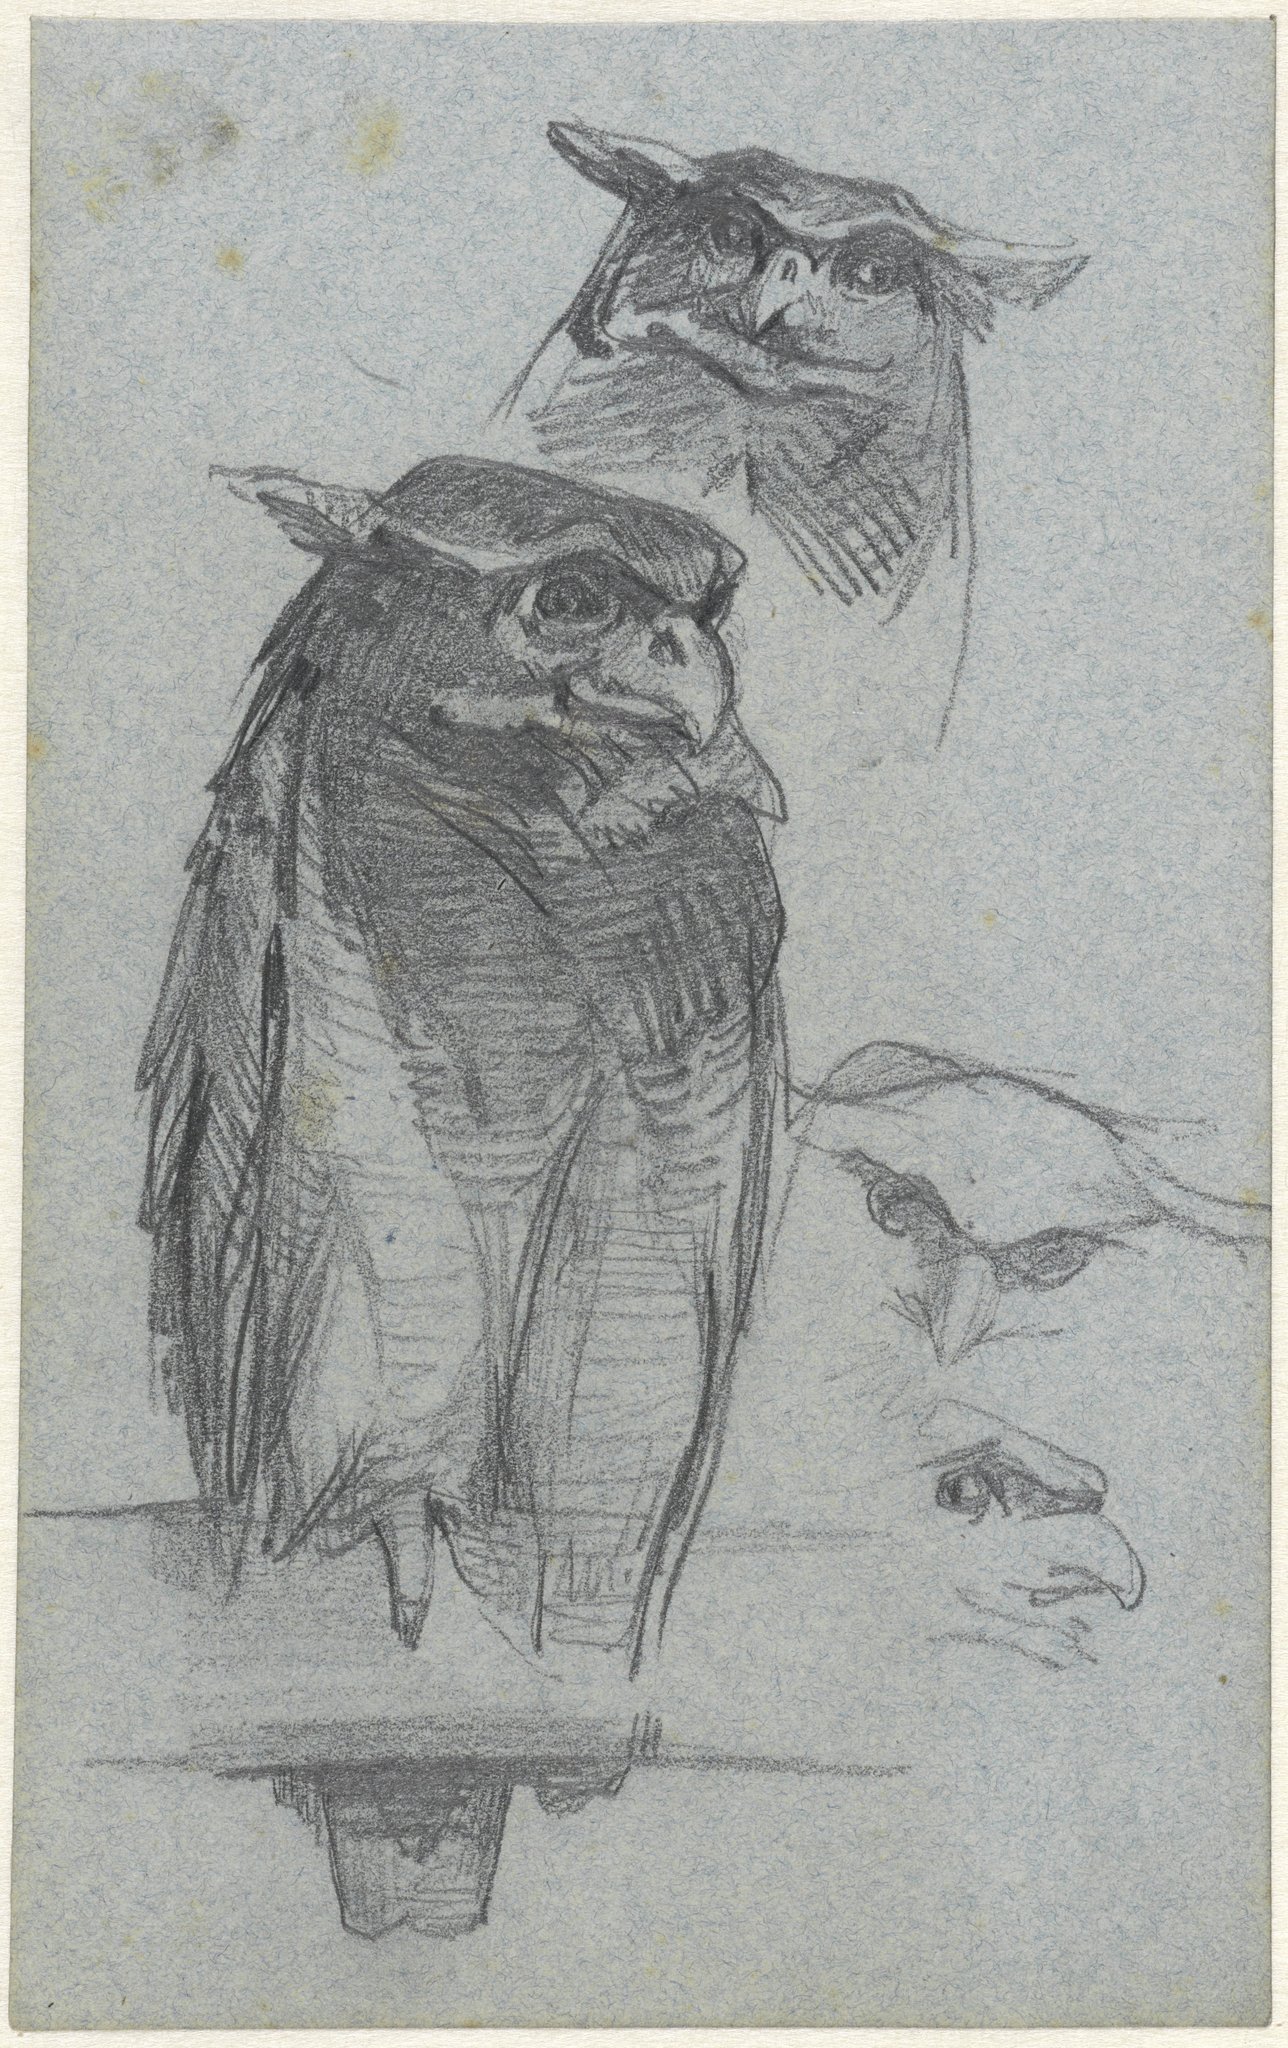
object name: drawing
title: Studies van een uil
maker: jac van looij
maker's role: draughtsman, painter, print maker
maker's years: 1855-1930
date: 1865-1930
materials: chalk, paper, pencil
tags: owls